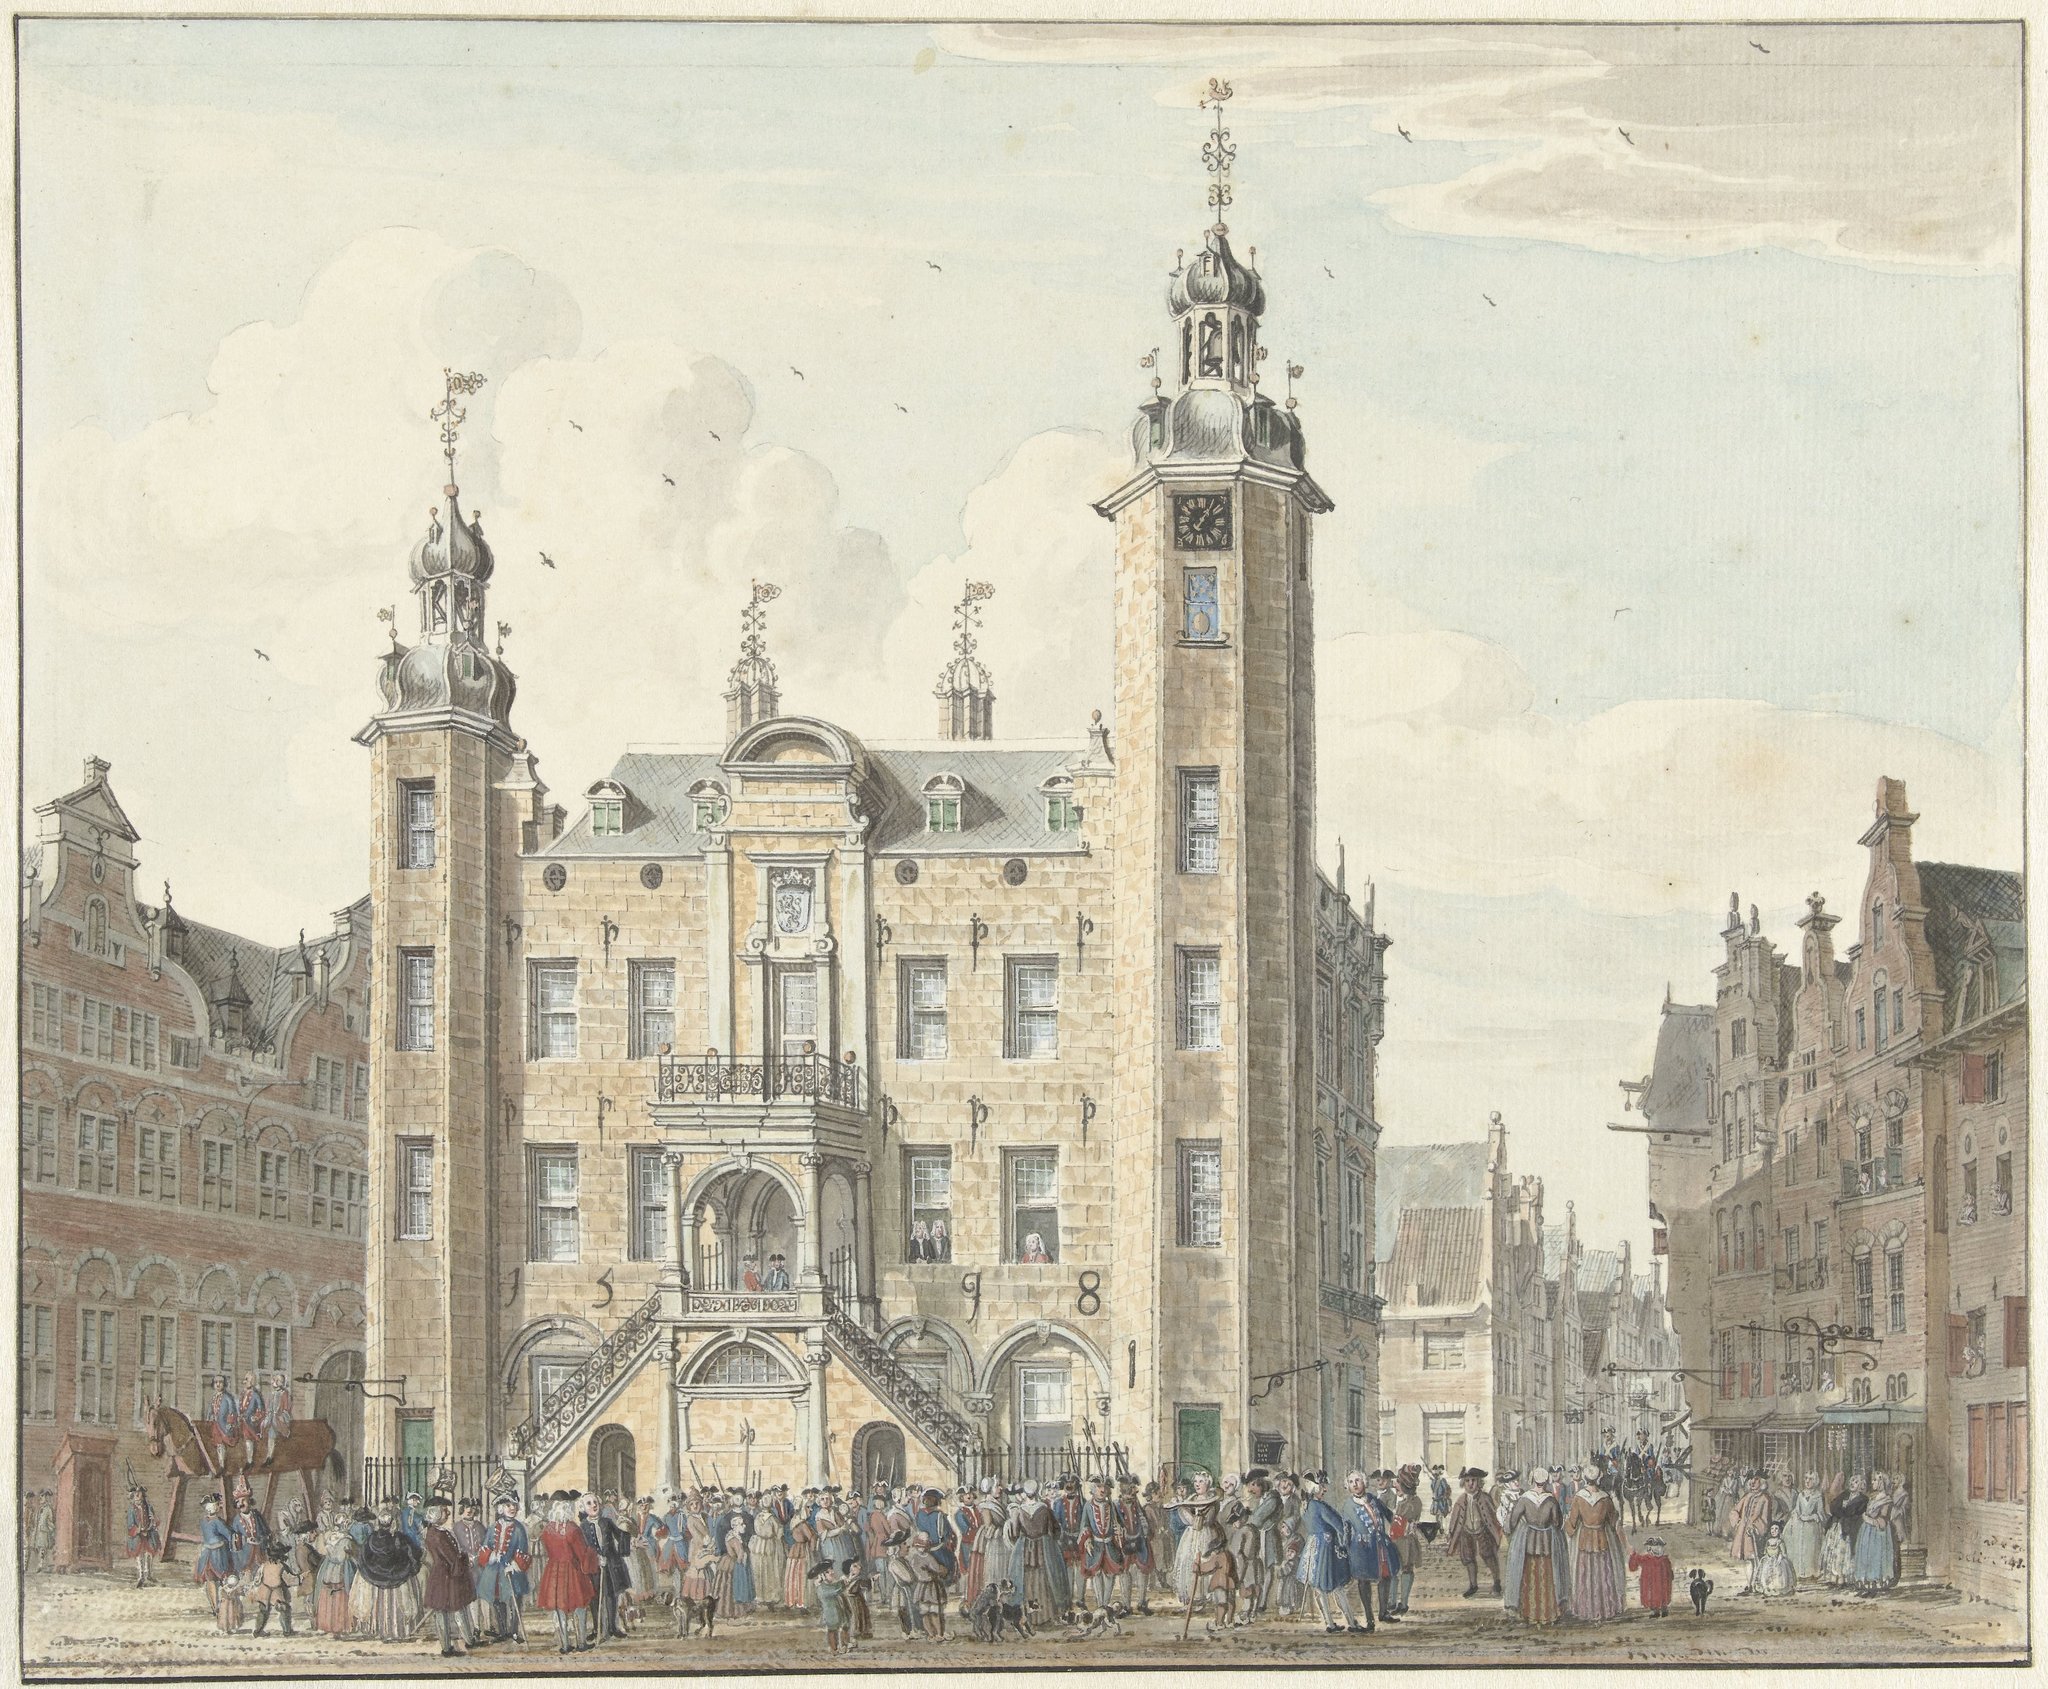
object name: watercolor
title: Het stadhuis van Venlo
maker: jan de beijer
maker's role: draughtsman, print maker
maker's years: 1703-1780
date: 1741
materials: paint, ink, paper, pencil, watercolor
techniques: brush, pen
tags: public road, municipal government